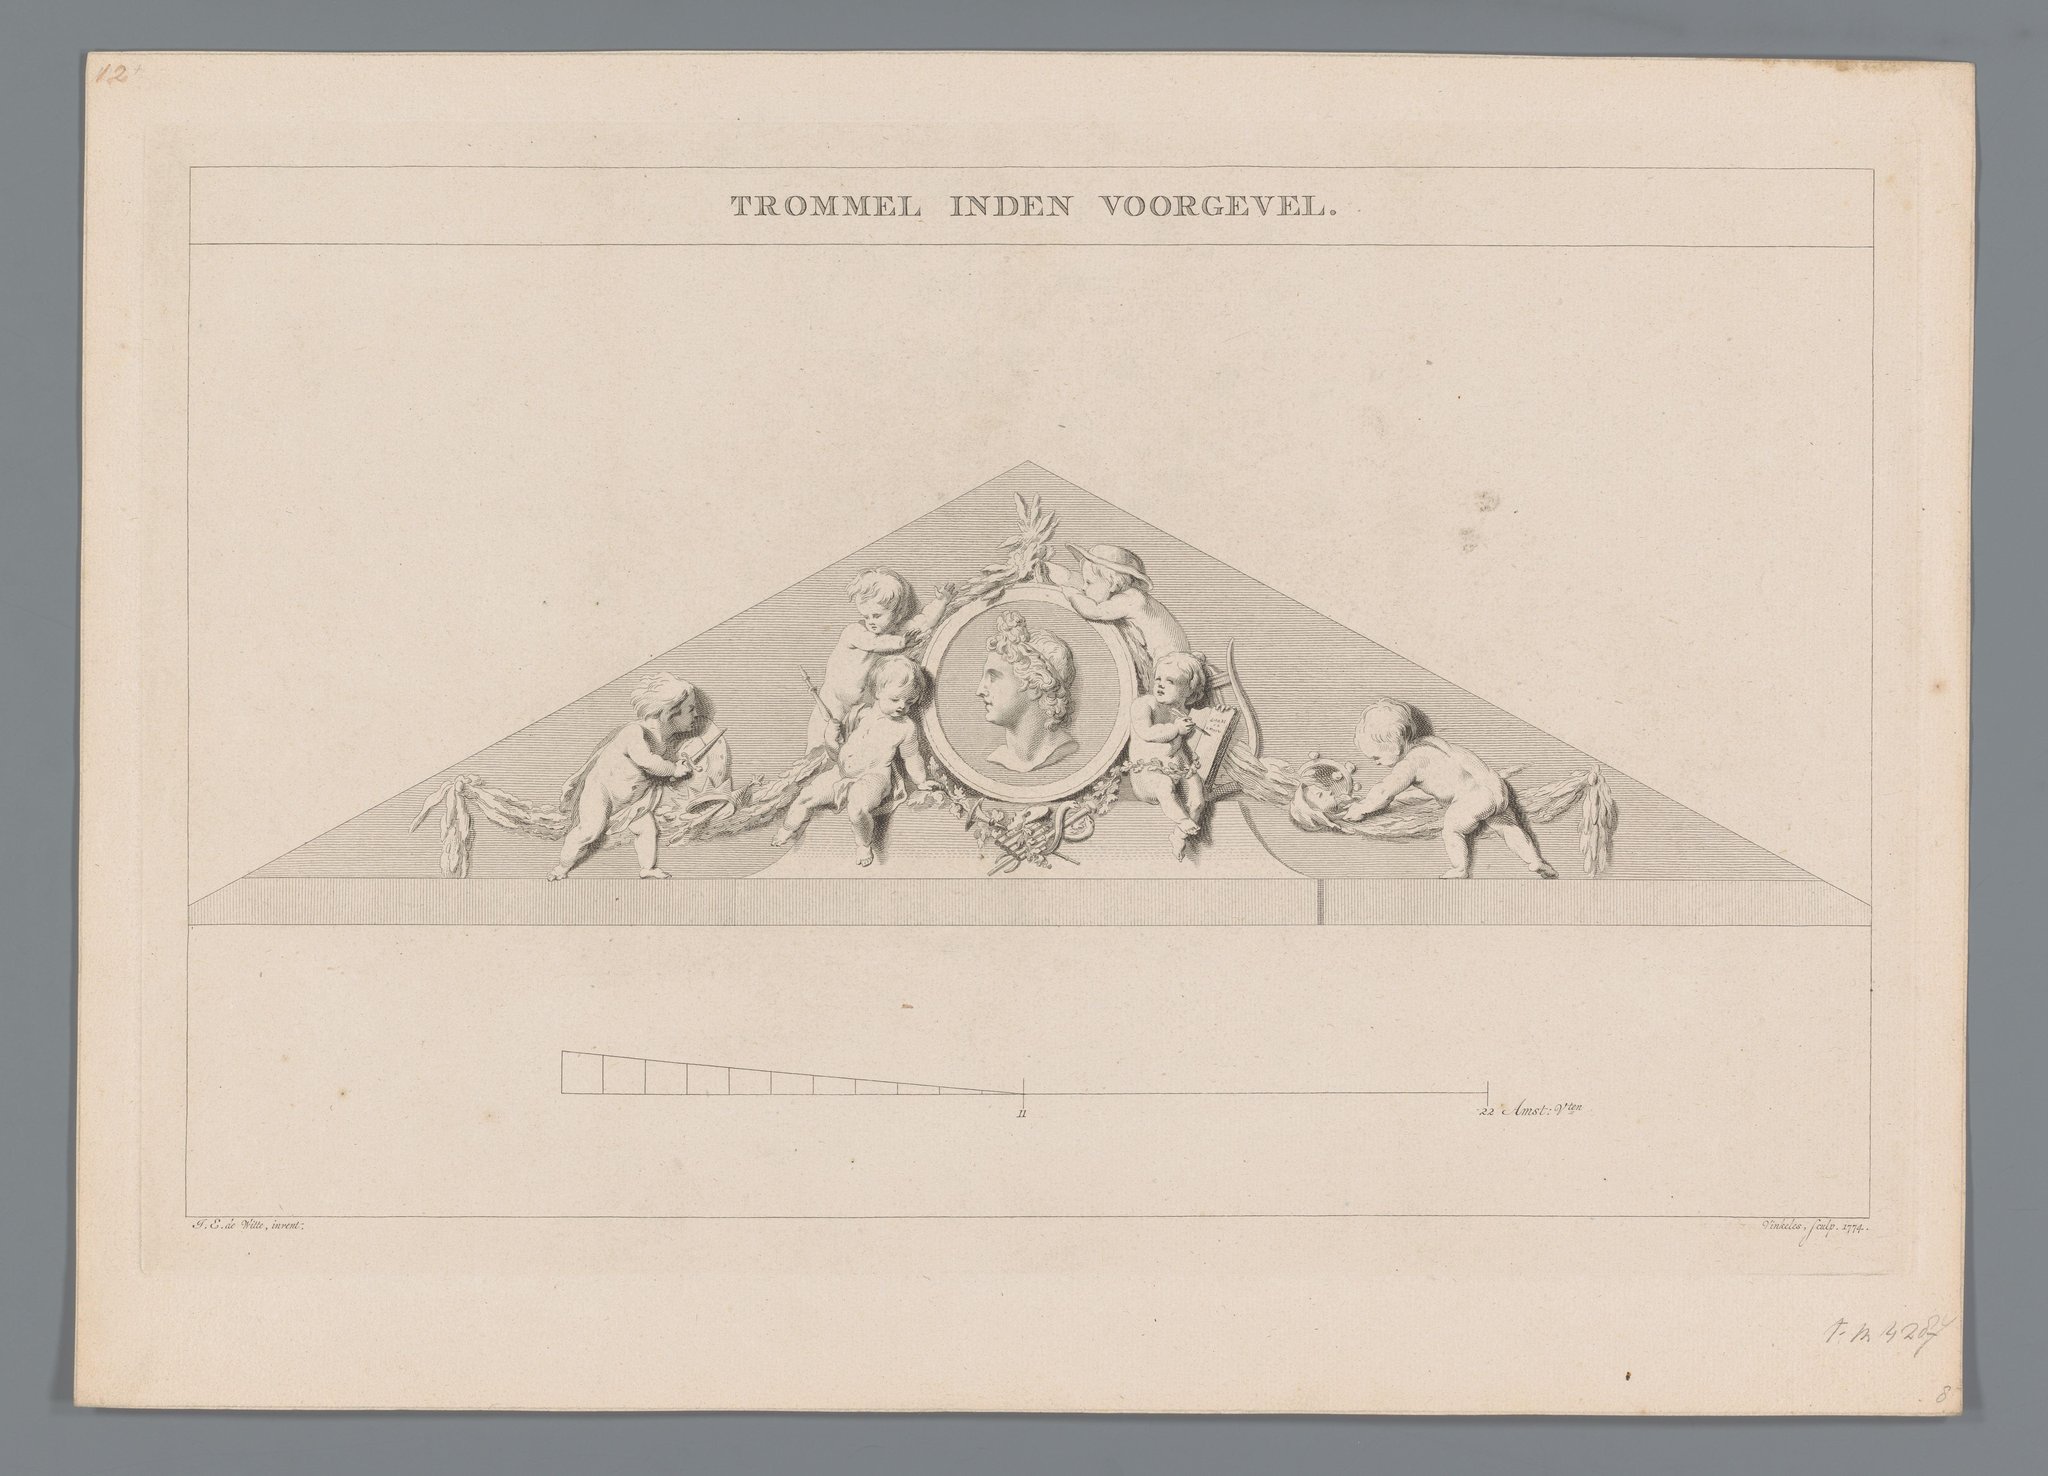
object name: print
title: Trommel inden voorgevel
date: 1774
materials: paper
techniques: etching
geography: amsterdam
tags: theatre (building), architectural design or model, cupids: 'amores', 'amoretti', 'putti', amsterdam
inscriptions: date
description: Prent uit: Witte, Jacob Eduard de. Afbeeldingen van den schouwburg te Amsterdam. Amsterdam: Johannes Smit, 1774.